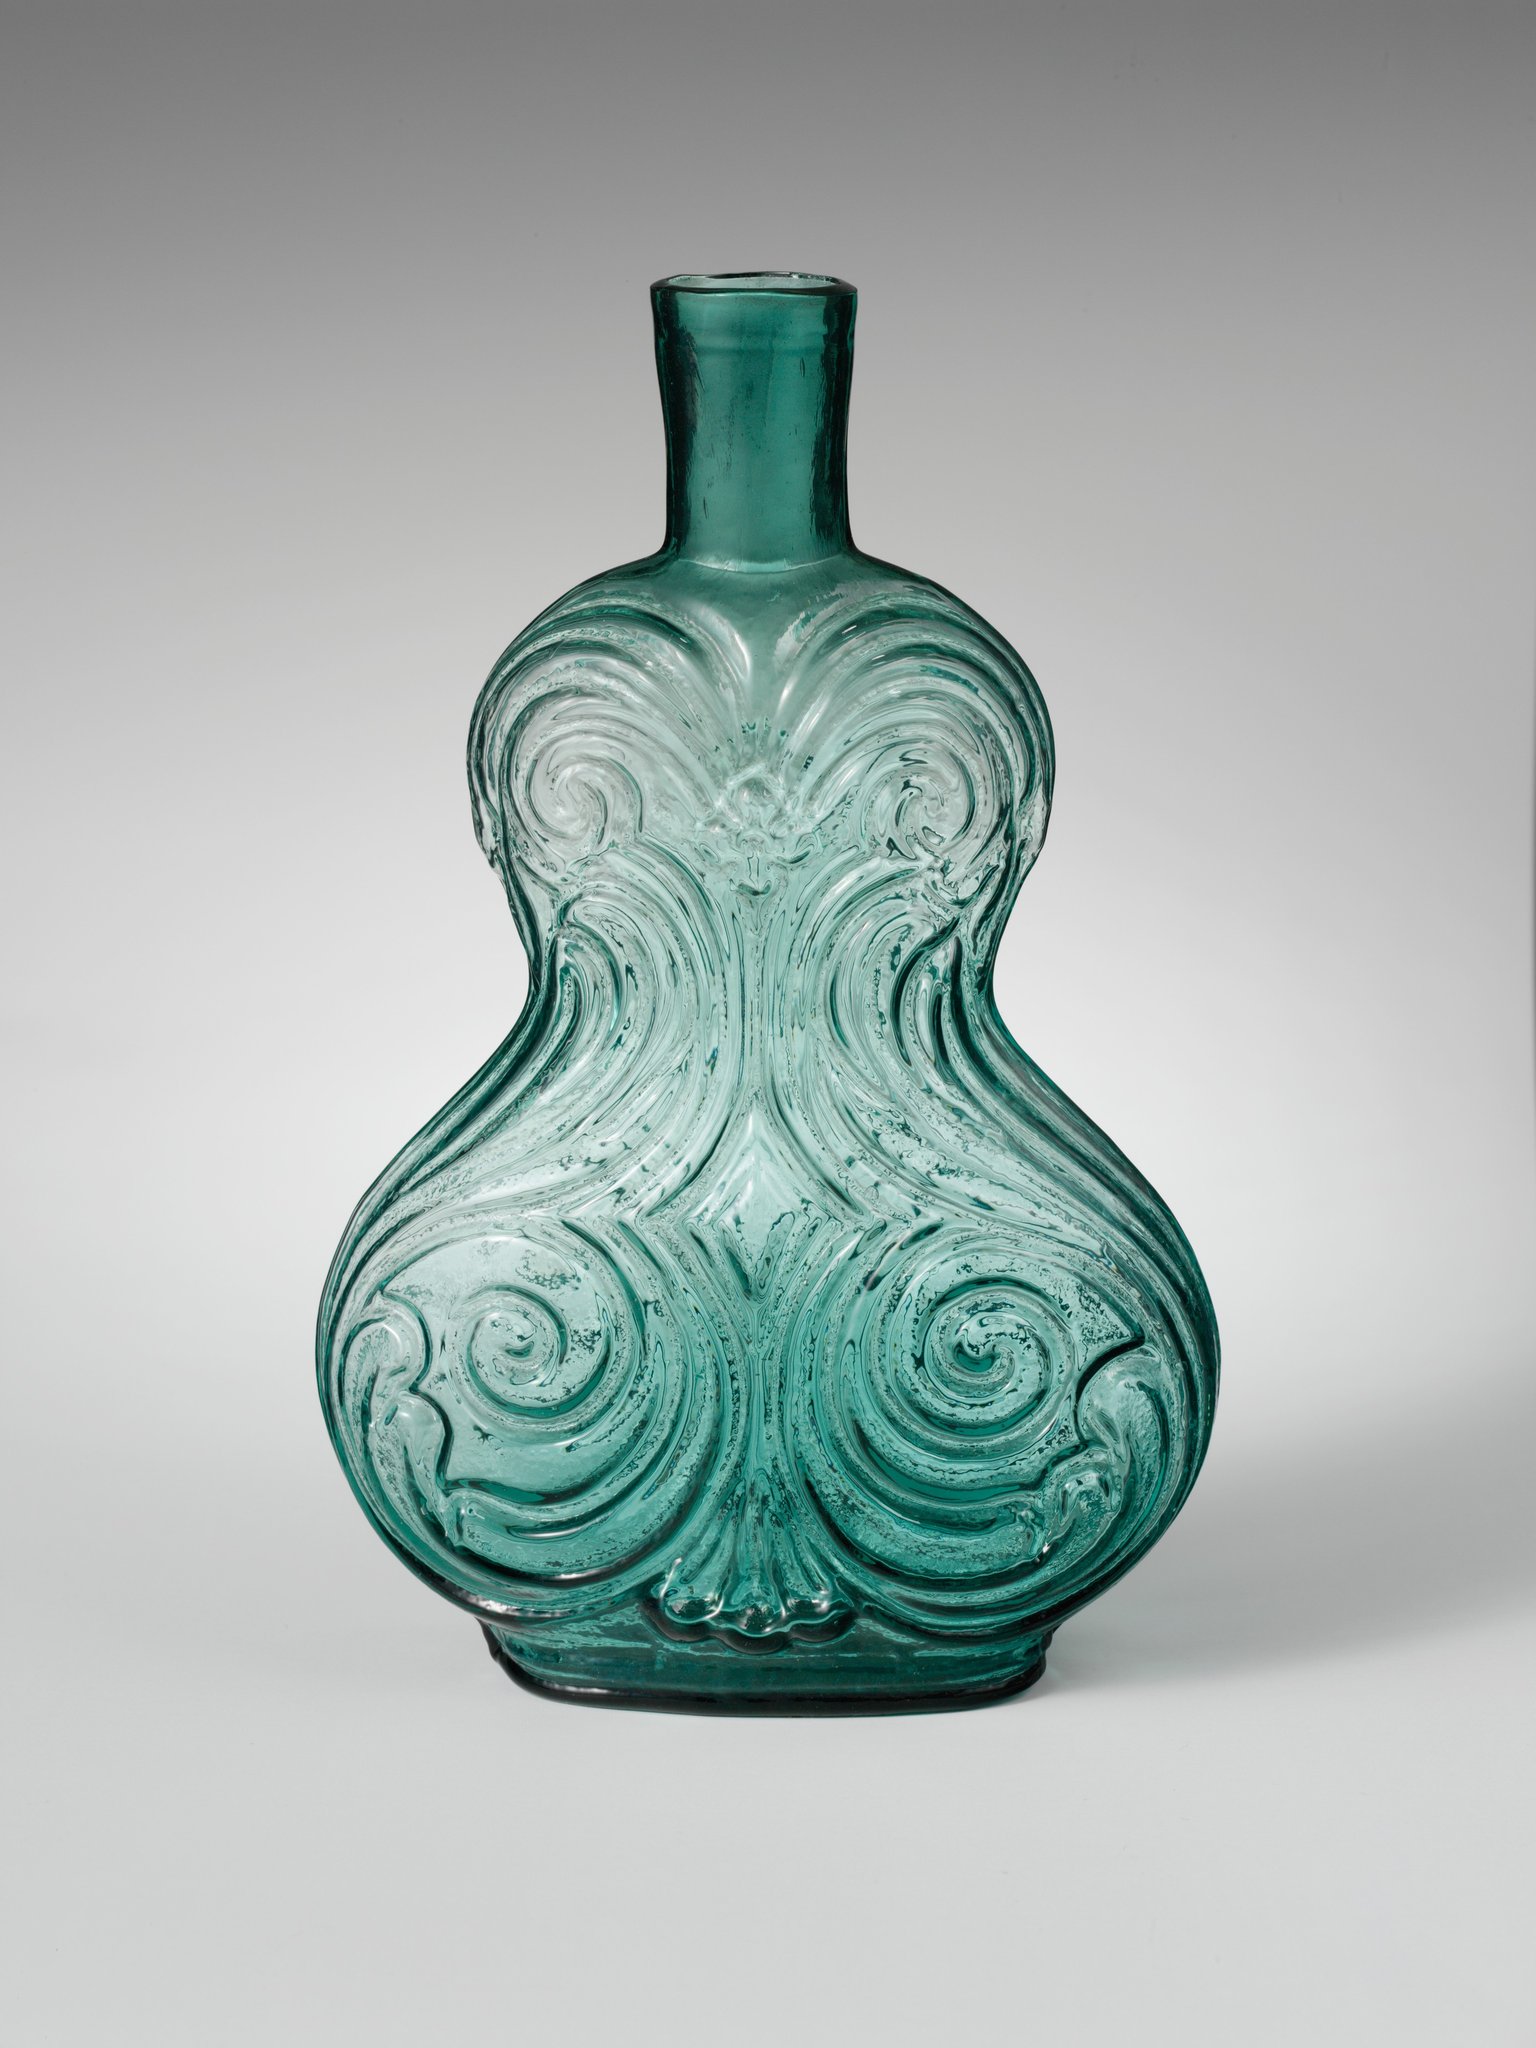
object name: flask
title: Scroll flask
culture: american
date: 1830-1840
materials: gemstone, glass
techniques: glassblowing, molding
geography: united states